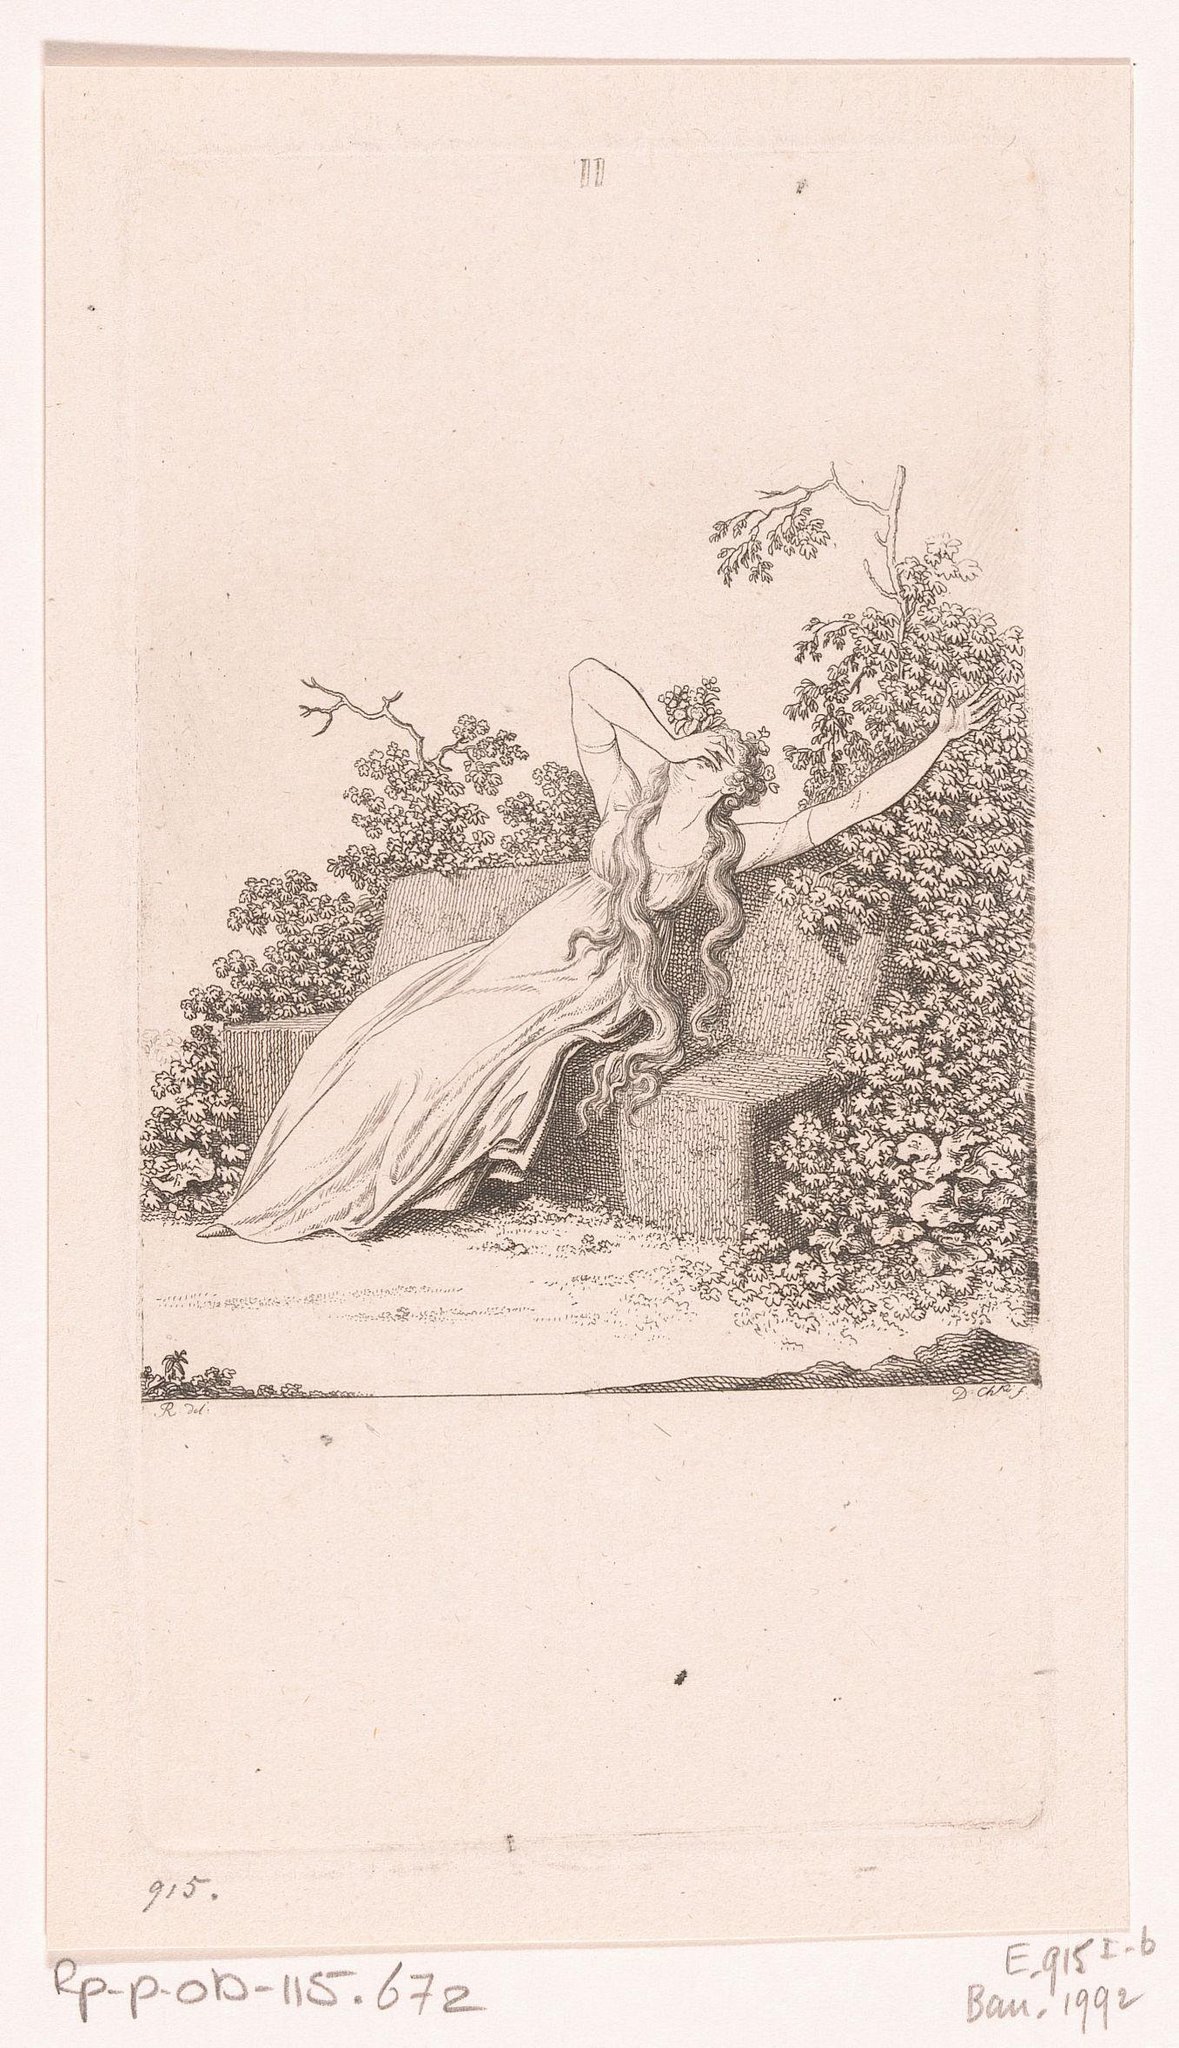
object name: print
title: Nina heft haar hand in wanhoop tot de hemel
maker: daniel nikolaus chodowiecki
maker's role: draughtsman, print maker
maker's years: 1726-1801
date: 1799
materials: paper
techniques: etching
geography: berlin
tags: berlin, bench, adolescent, young woman, maiden, despair; 'disperatione' (ripa)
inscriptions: collector's mark: Lugt 2228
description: Prent gebruikt voor: Rhode, Johann Gottlieb. Berlin, eine Zeitschrift für Freunde der schöne Künste, des Geschmacks und der Moden (...). Berlijn: Decker, 1799-1800.